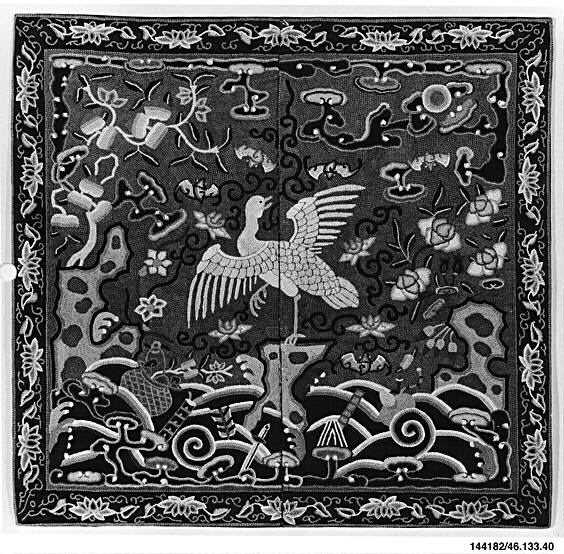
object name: rank badge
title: Rank Badge with Wild Goose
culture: chinese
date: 1734-1766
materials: silk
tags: bats,geese